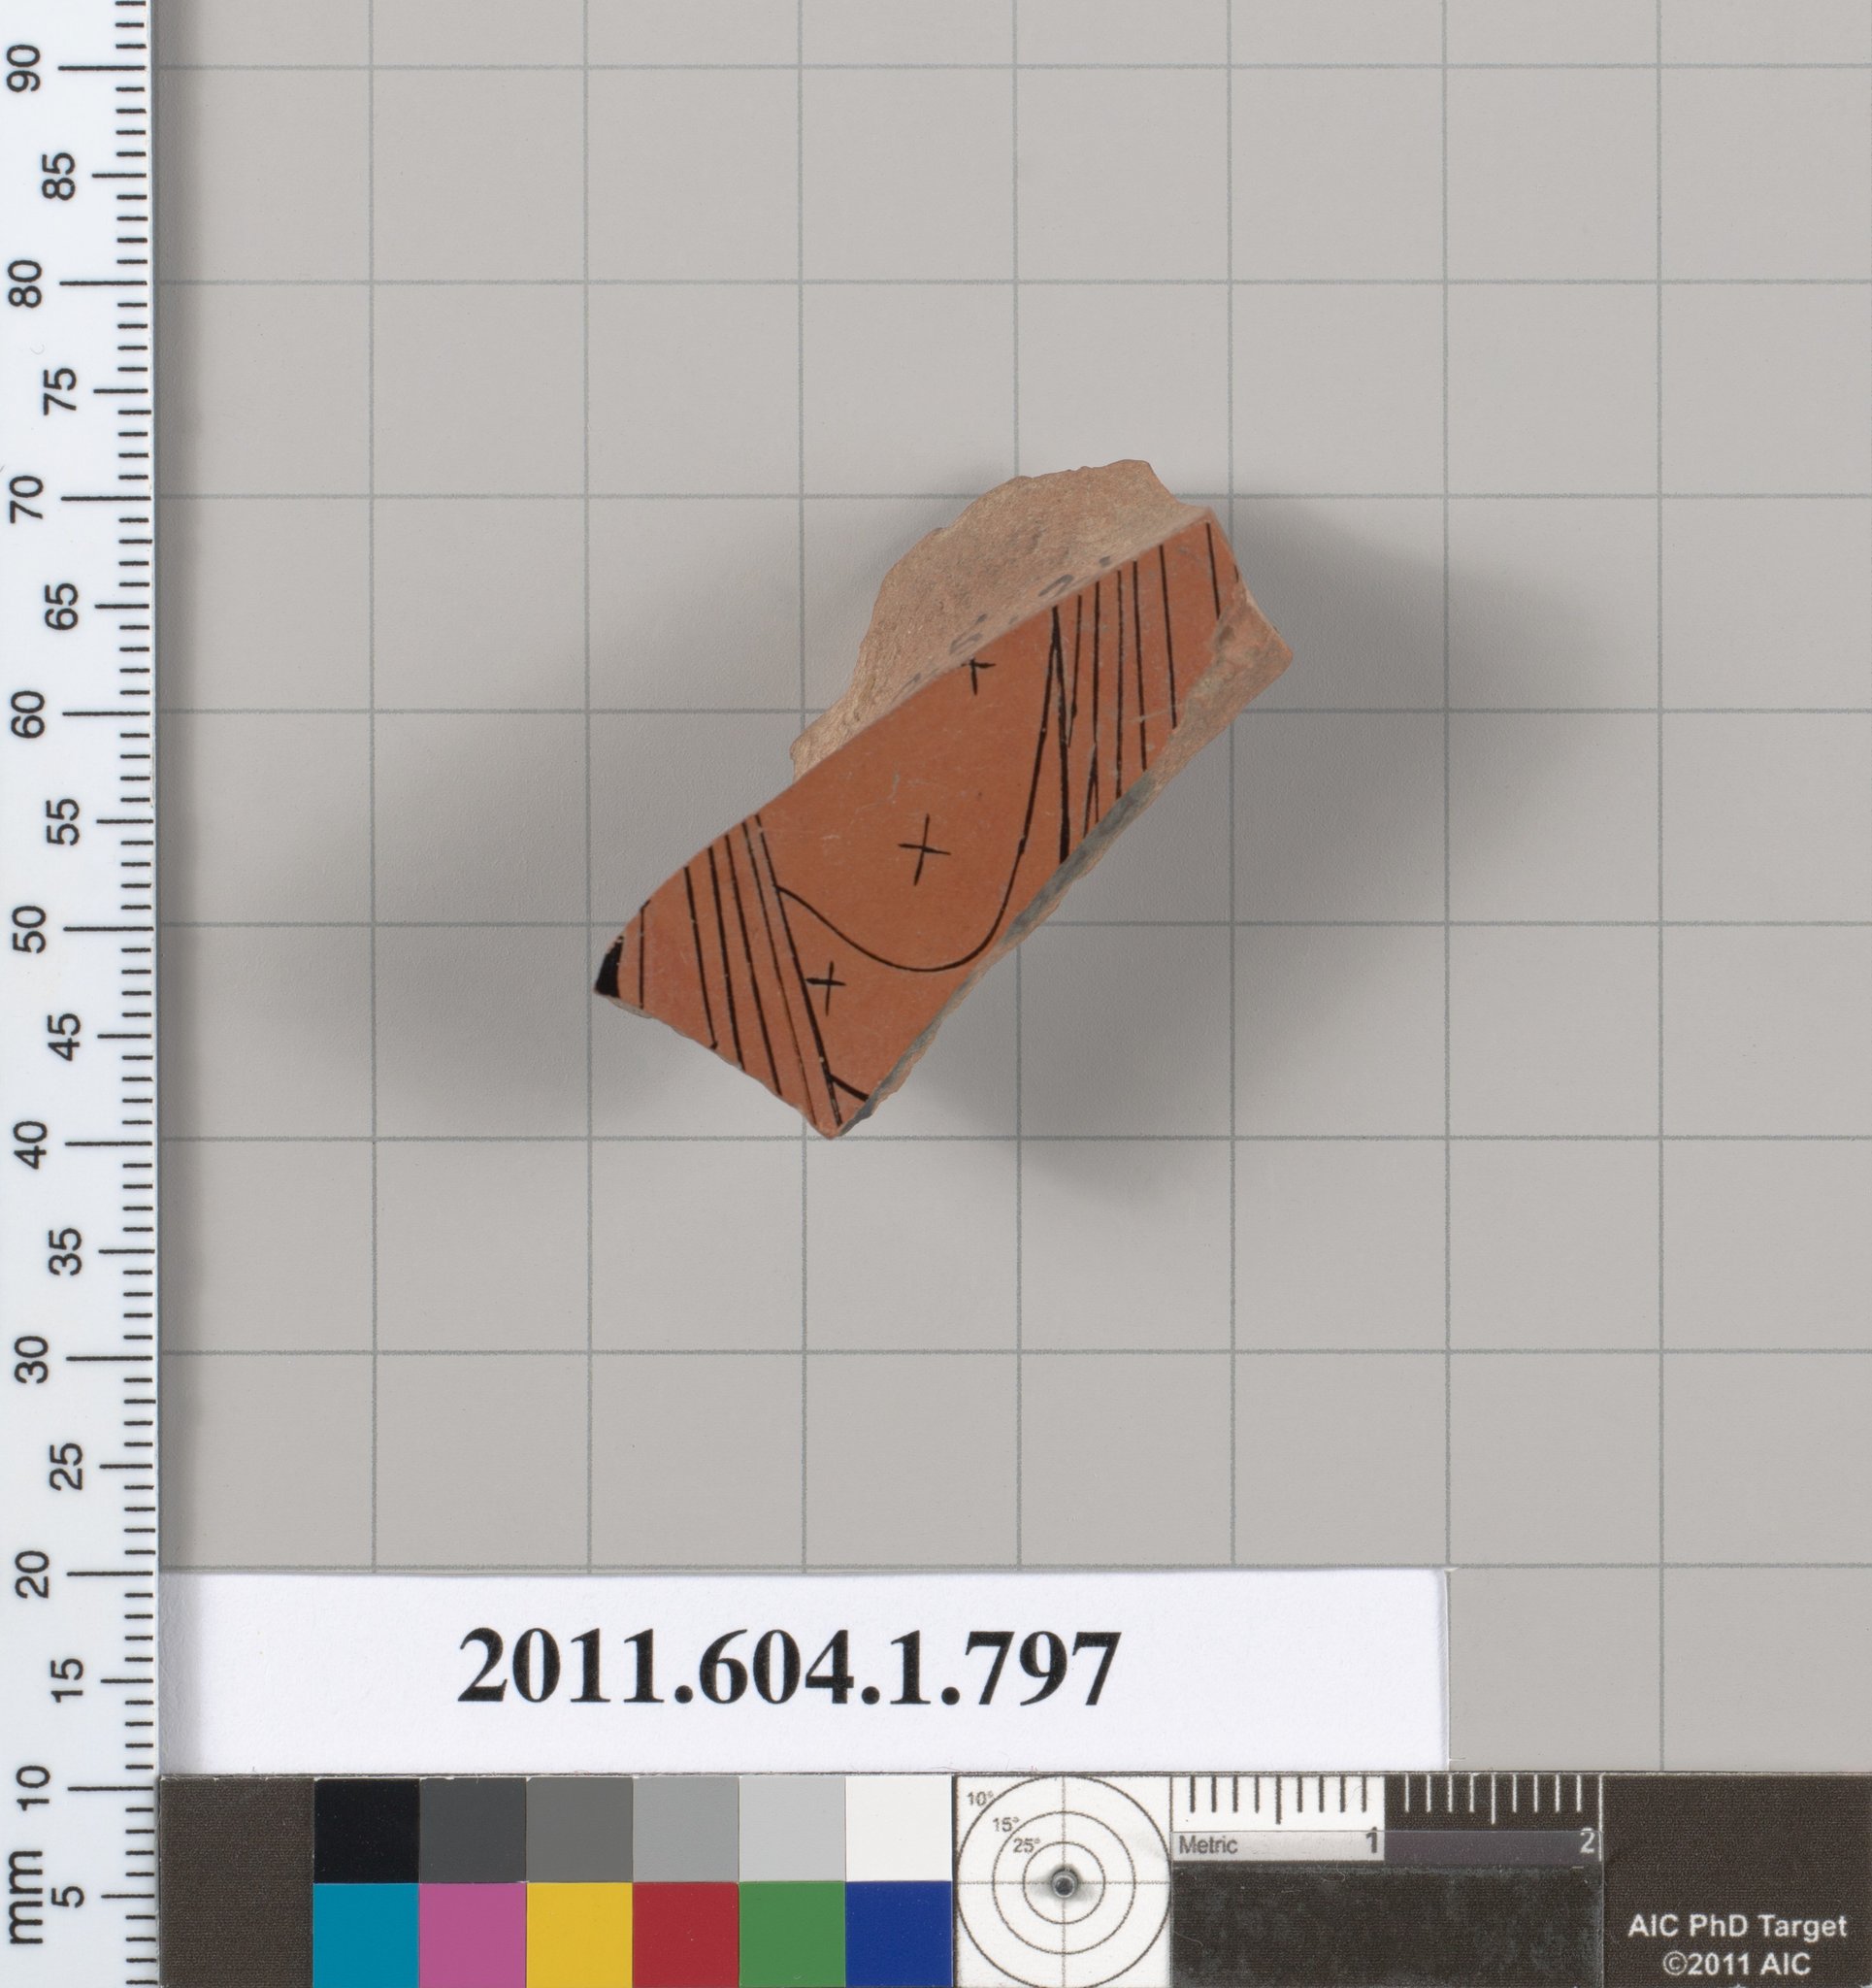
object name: kylix fragment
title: Terracotta fragment of a kylix (drinking cup)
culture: greek, attic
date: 490-480 BCE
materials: terracotta